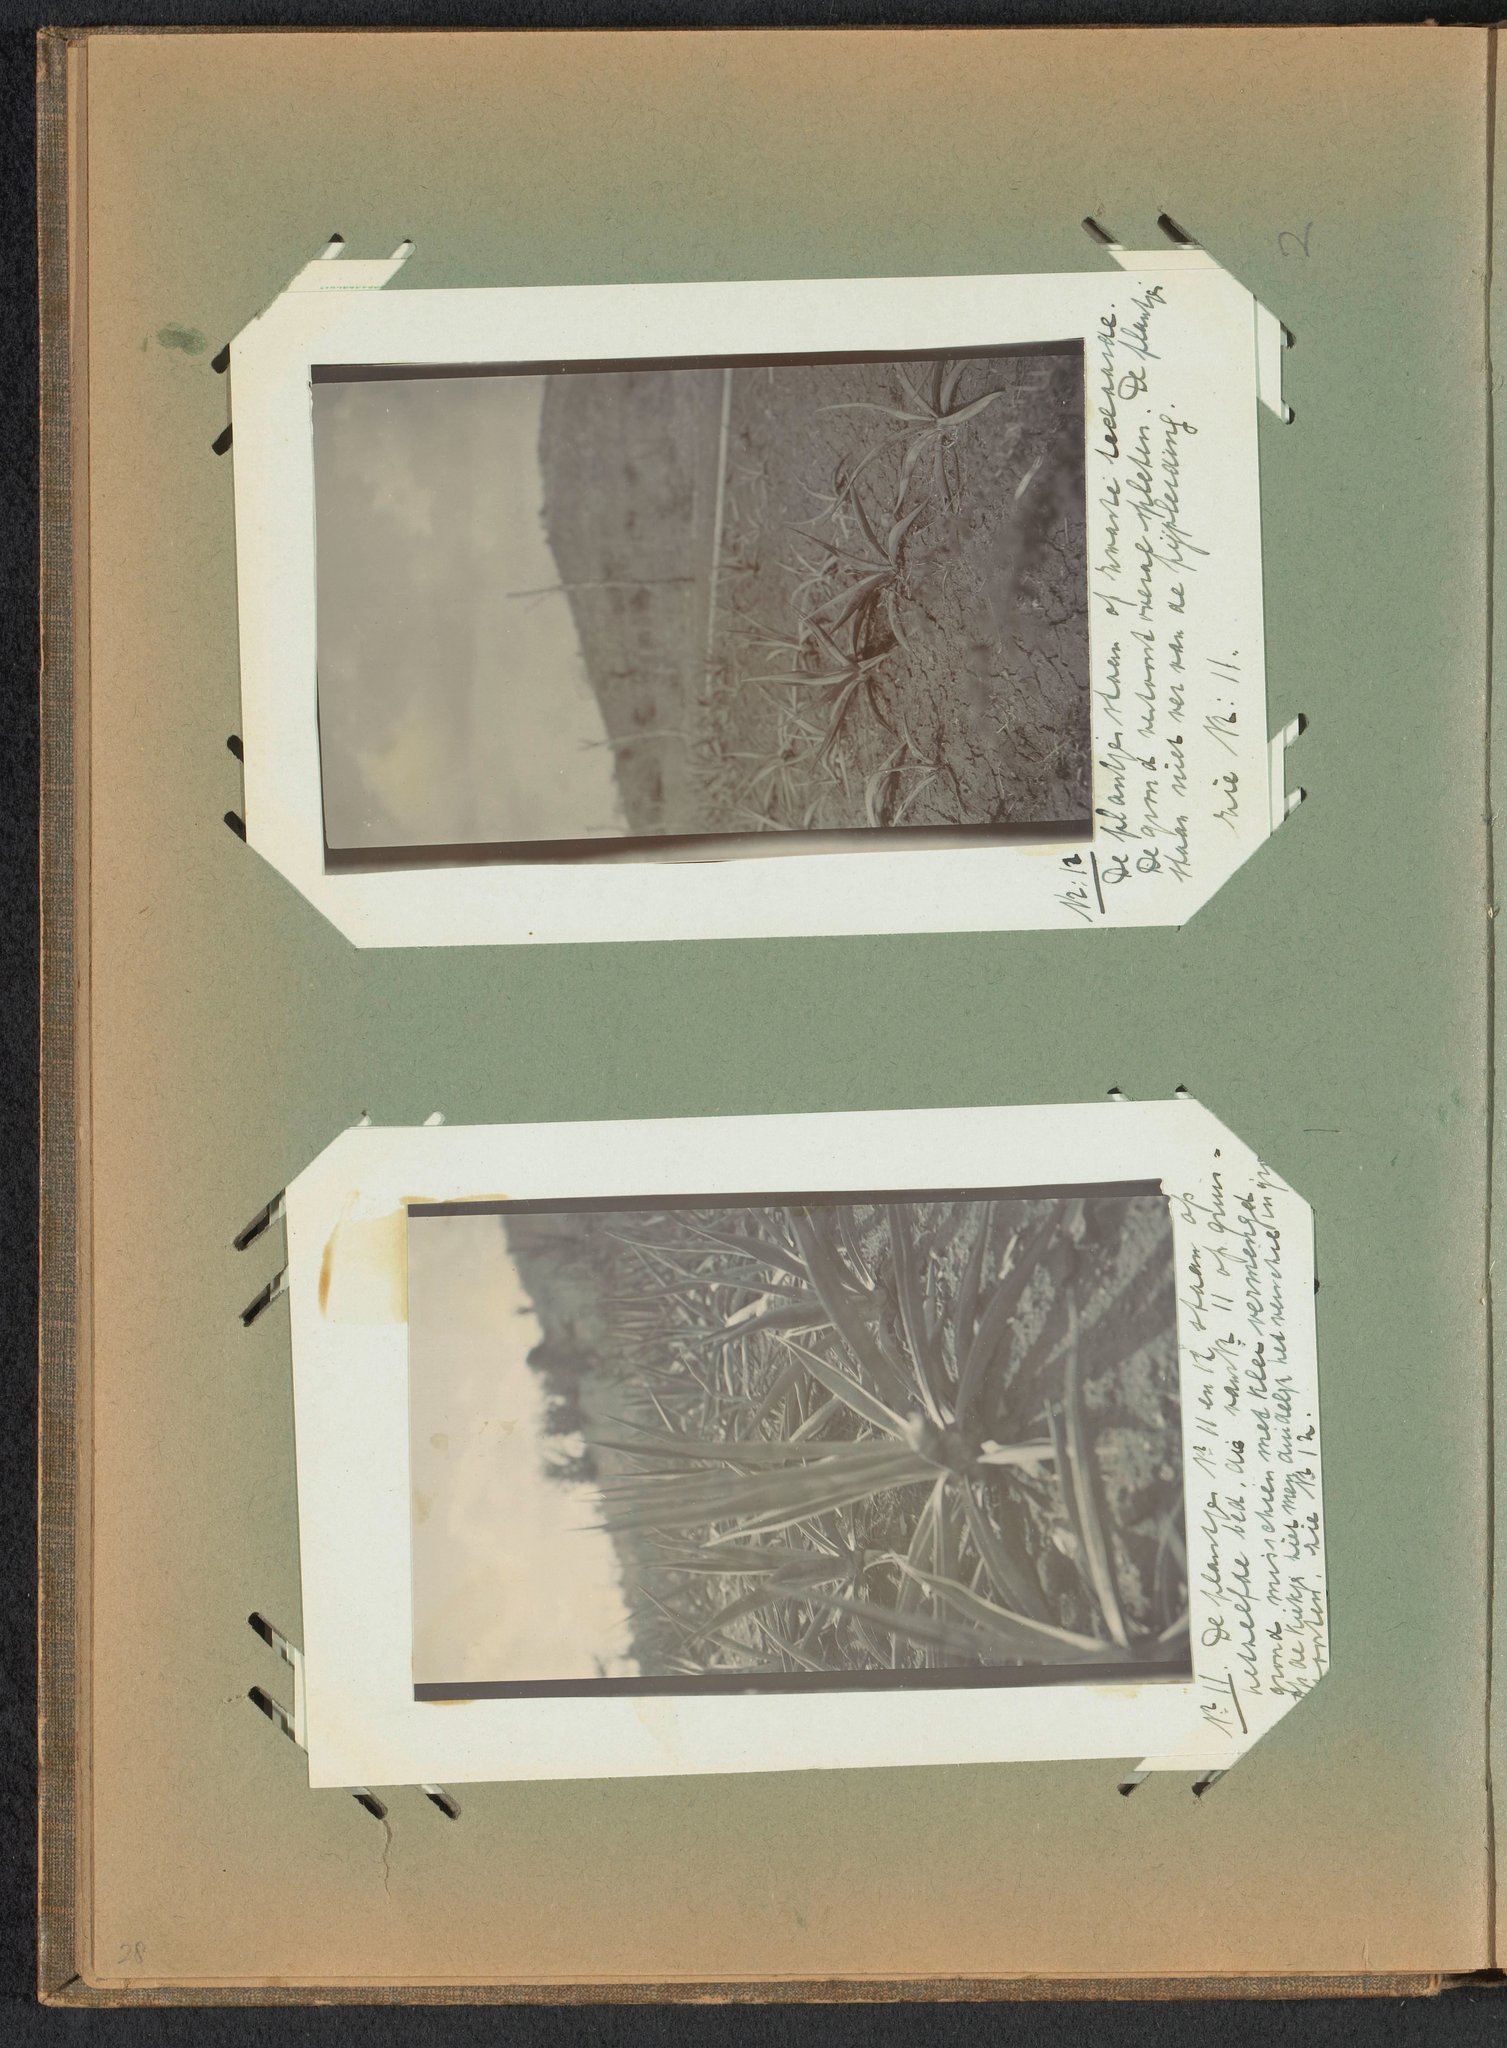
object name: photograph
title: Nr. 11 De plantjes nr. 11 en 12 staan op hetzelfde bed (...)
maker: Anonymous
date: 1912-1913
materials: paper, photographic support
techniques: gelatin silver print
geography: curacao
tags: plantation, (non-fruit) products of plants or trees: sisal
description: Aanplant van sisal op Plantage Mount Pleasant op Curaçao. Onderdeel van het fotoalbum uit ca. 1912-1913 met 92 foto's van de plantages Peperpot en Dordrecht in Suriname en Mount Pleasant op Curaçao.